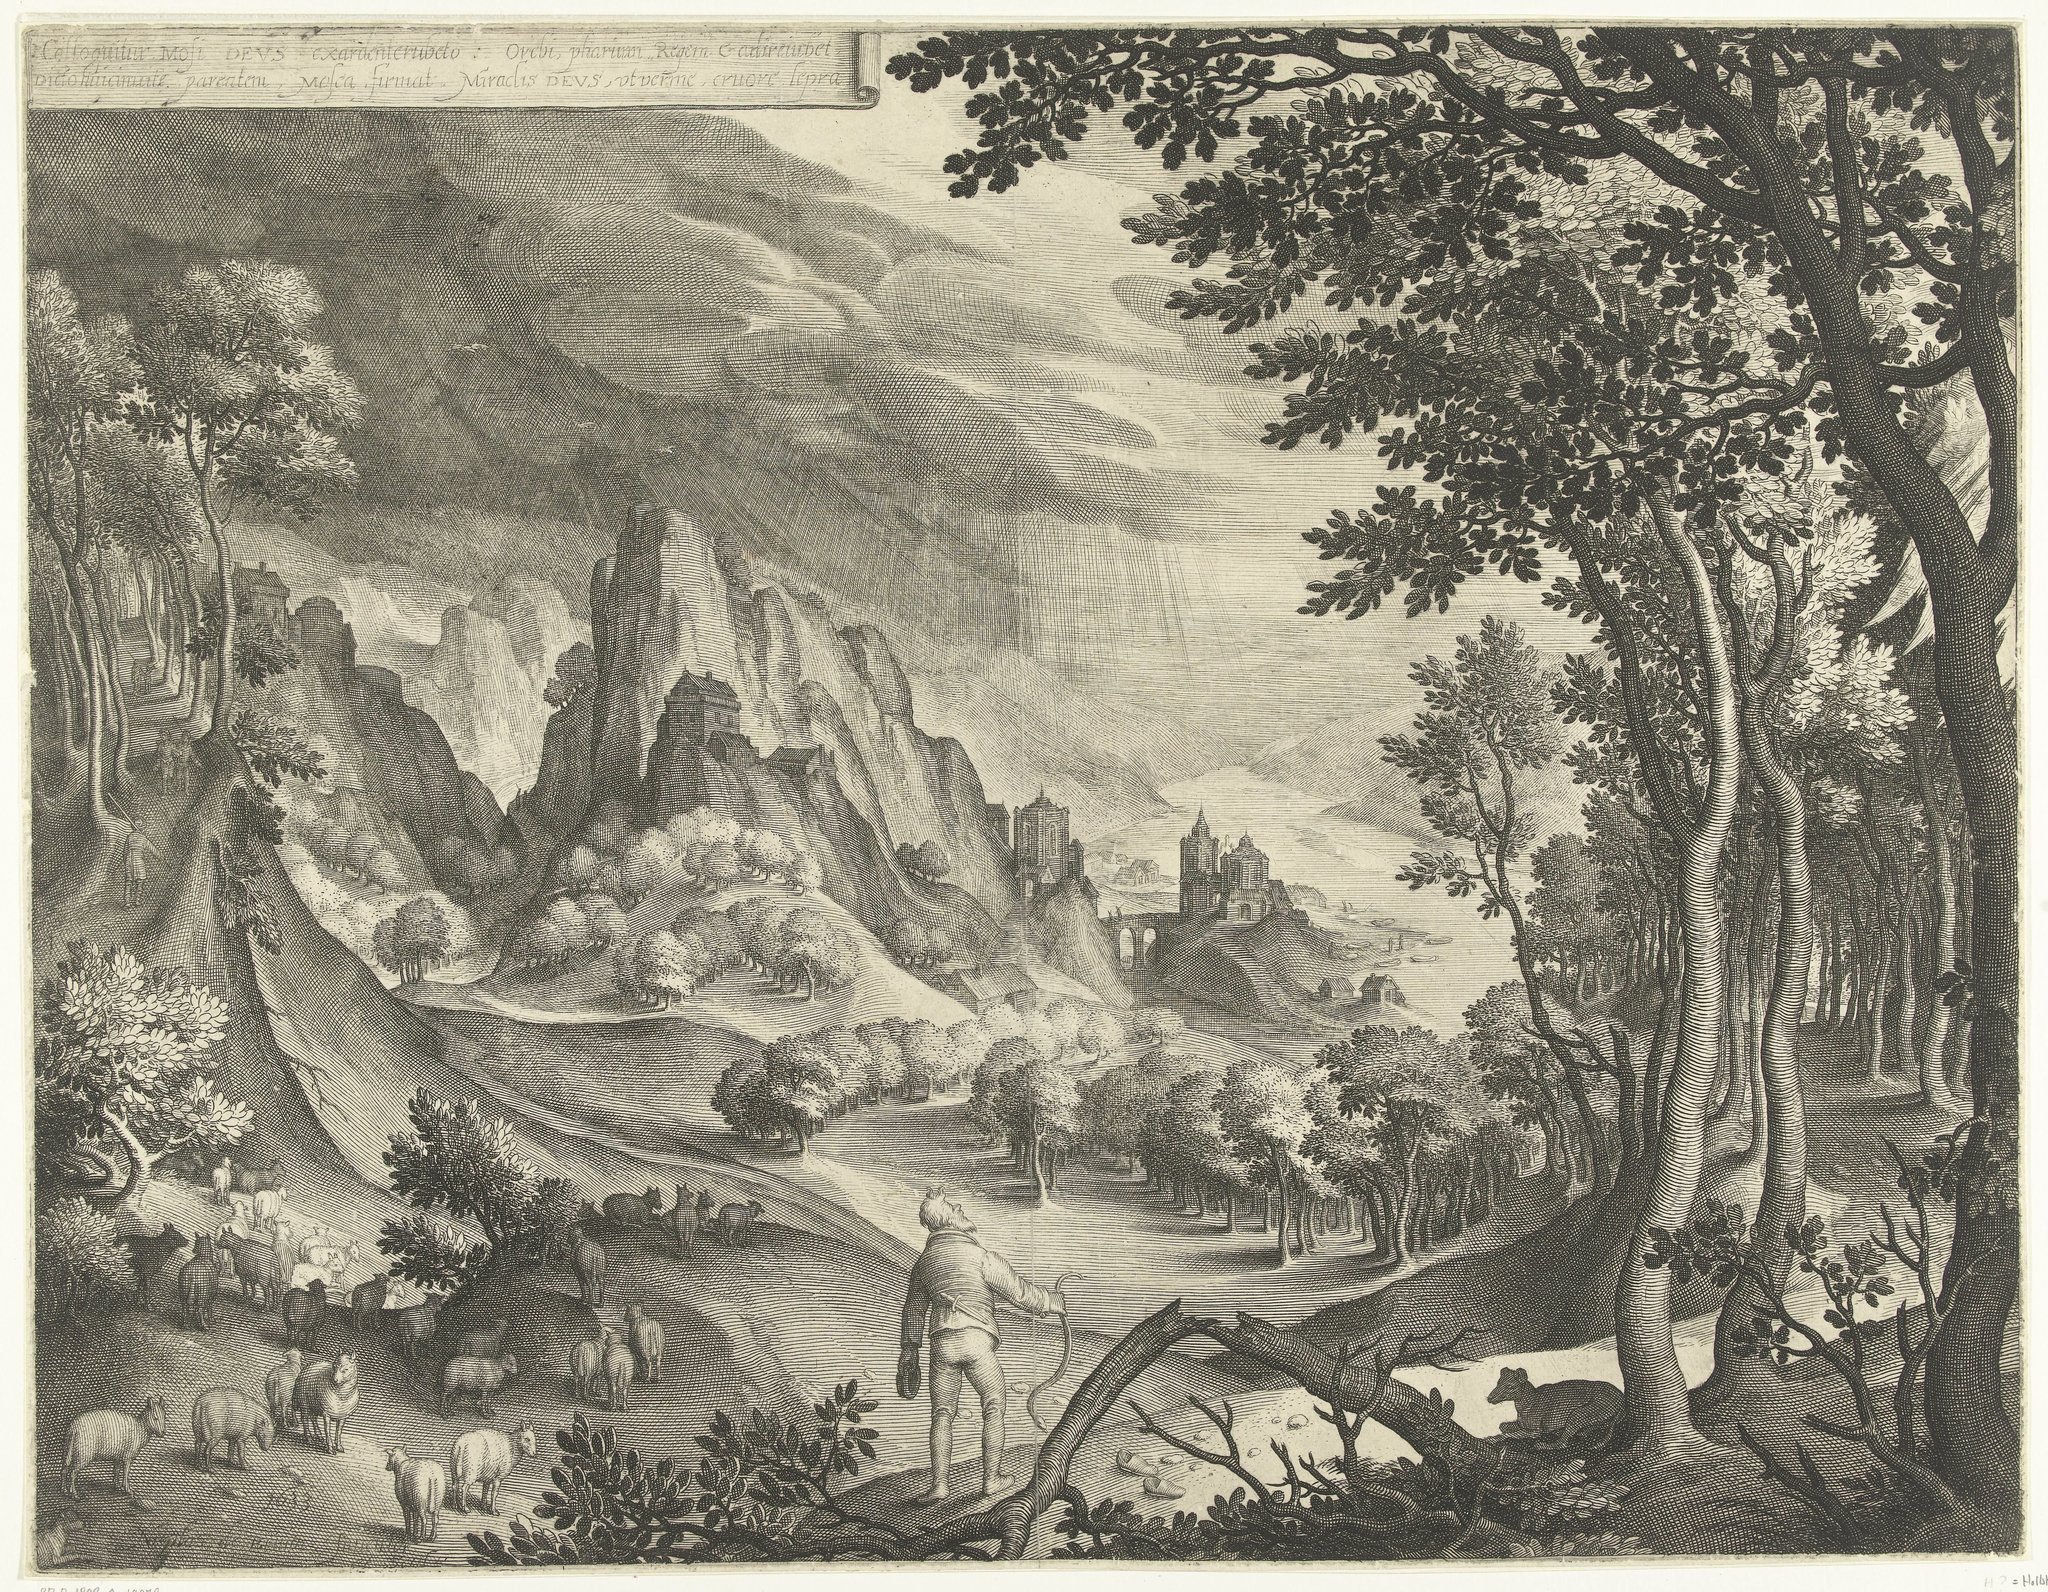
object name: print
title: Mozes wordt aangesproken door God op de berg Horeb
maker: nicolaes de bruyn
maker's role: print maker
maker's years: 1571-1656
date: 1633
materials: paper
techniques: engraving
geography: netherlands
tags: a burning bush attracts moses' attention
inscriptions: collector's mark: Lugt 2228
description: Mozes staat met een slang in zijn hand op de berg Horeb (zijn herdersstaf is veranderd in een slang). Uit respect voor de heilige grond heeft hij zijn sandalen uitgetrokken en hij kijkt naar de hemel. Zijn kudde schapen graast op een helling. Het opschrift in Latijn op een cartouche verwijst naar het visioen van de brandende braamstruik maar deze is niet daadwerkelijk te zien.